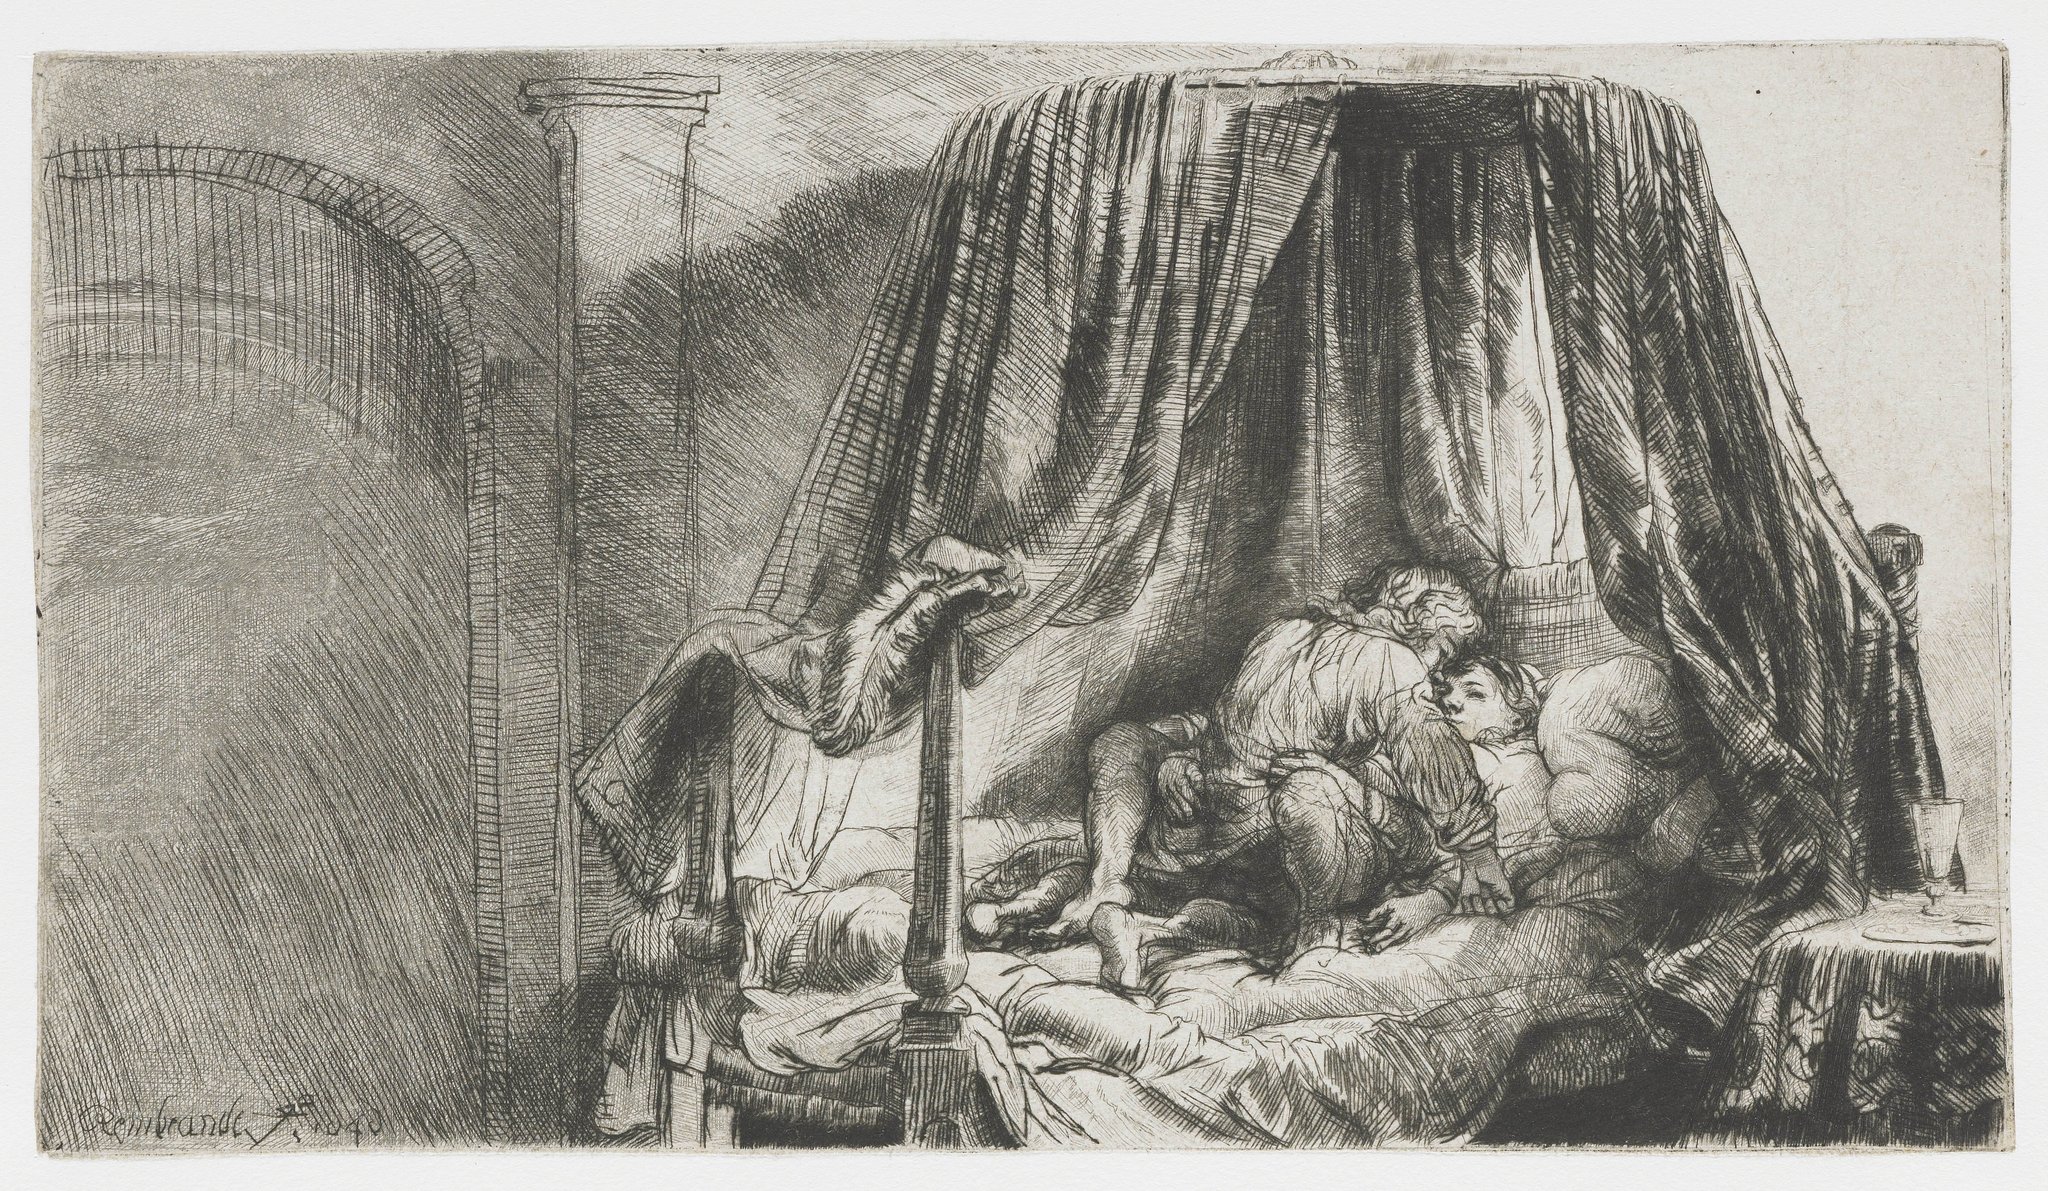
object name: print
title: The French bed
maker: rembrandt van rijn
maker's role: draughtsman, painter, print maker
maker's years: 1606-1669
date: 1646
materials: paper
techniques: drypoint, engraving, etching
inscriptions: date